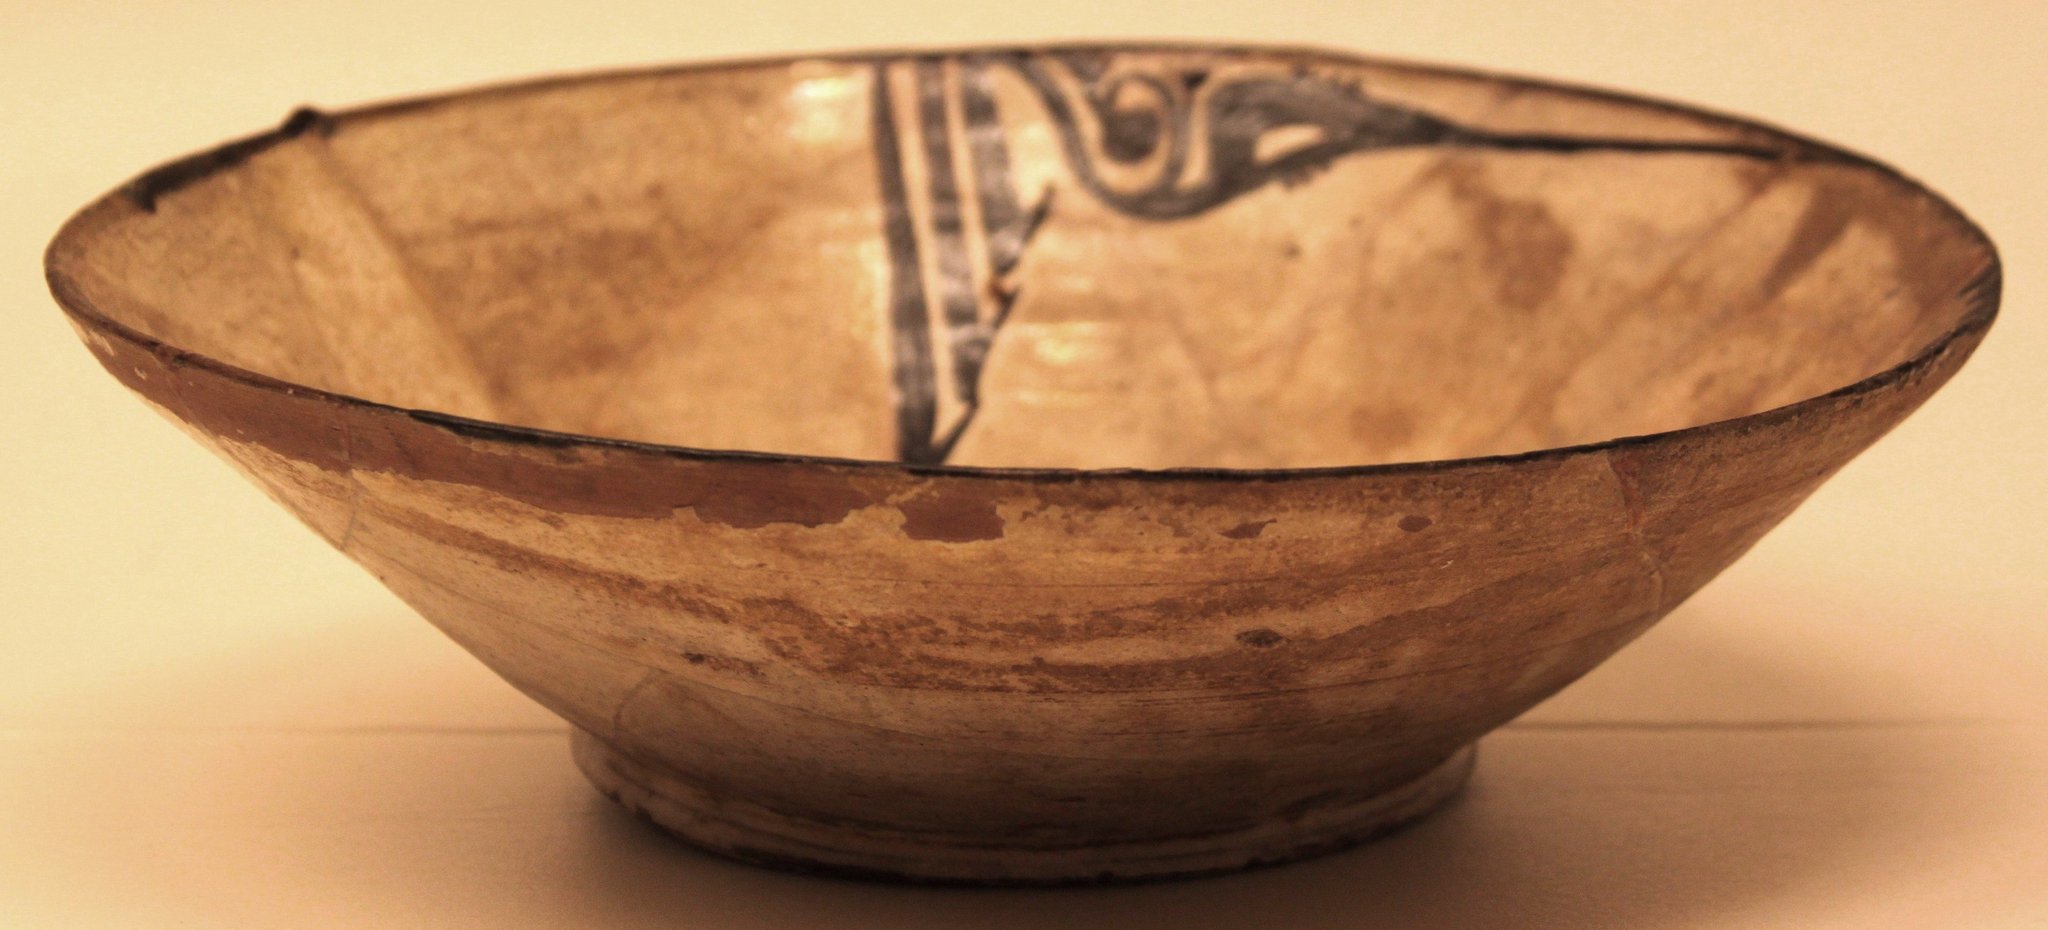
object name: bowl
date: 867-933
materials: earthenware, glaze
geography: iran